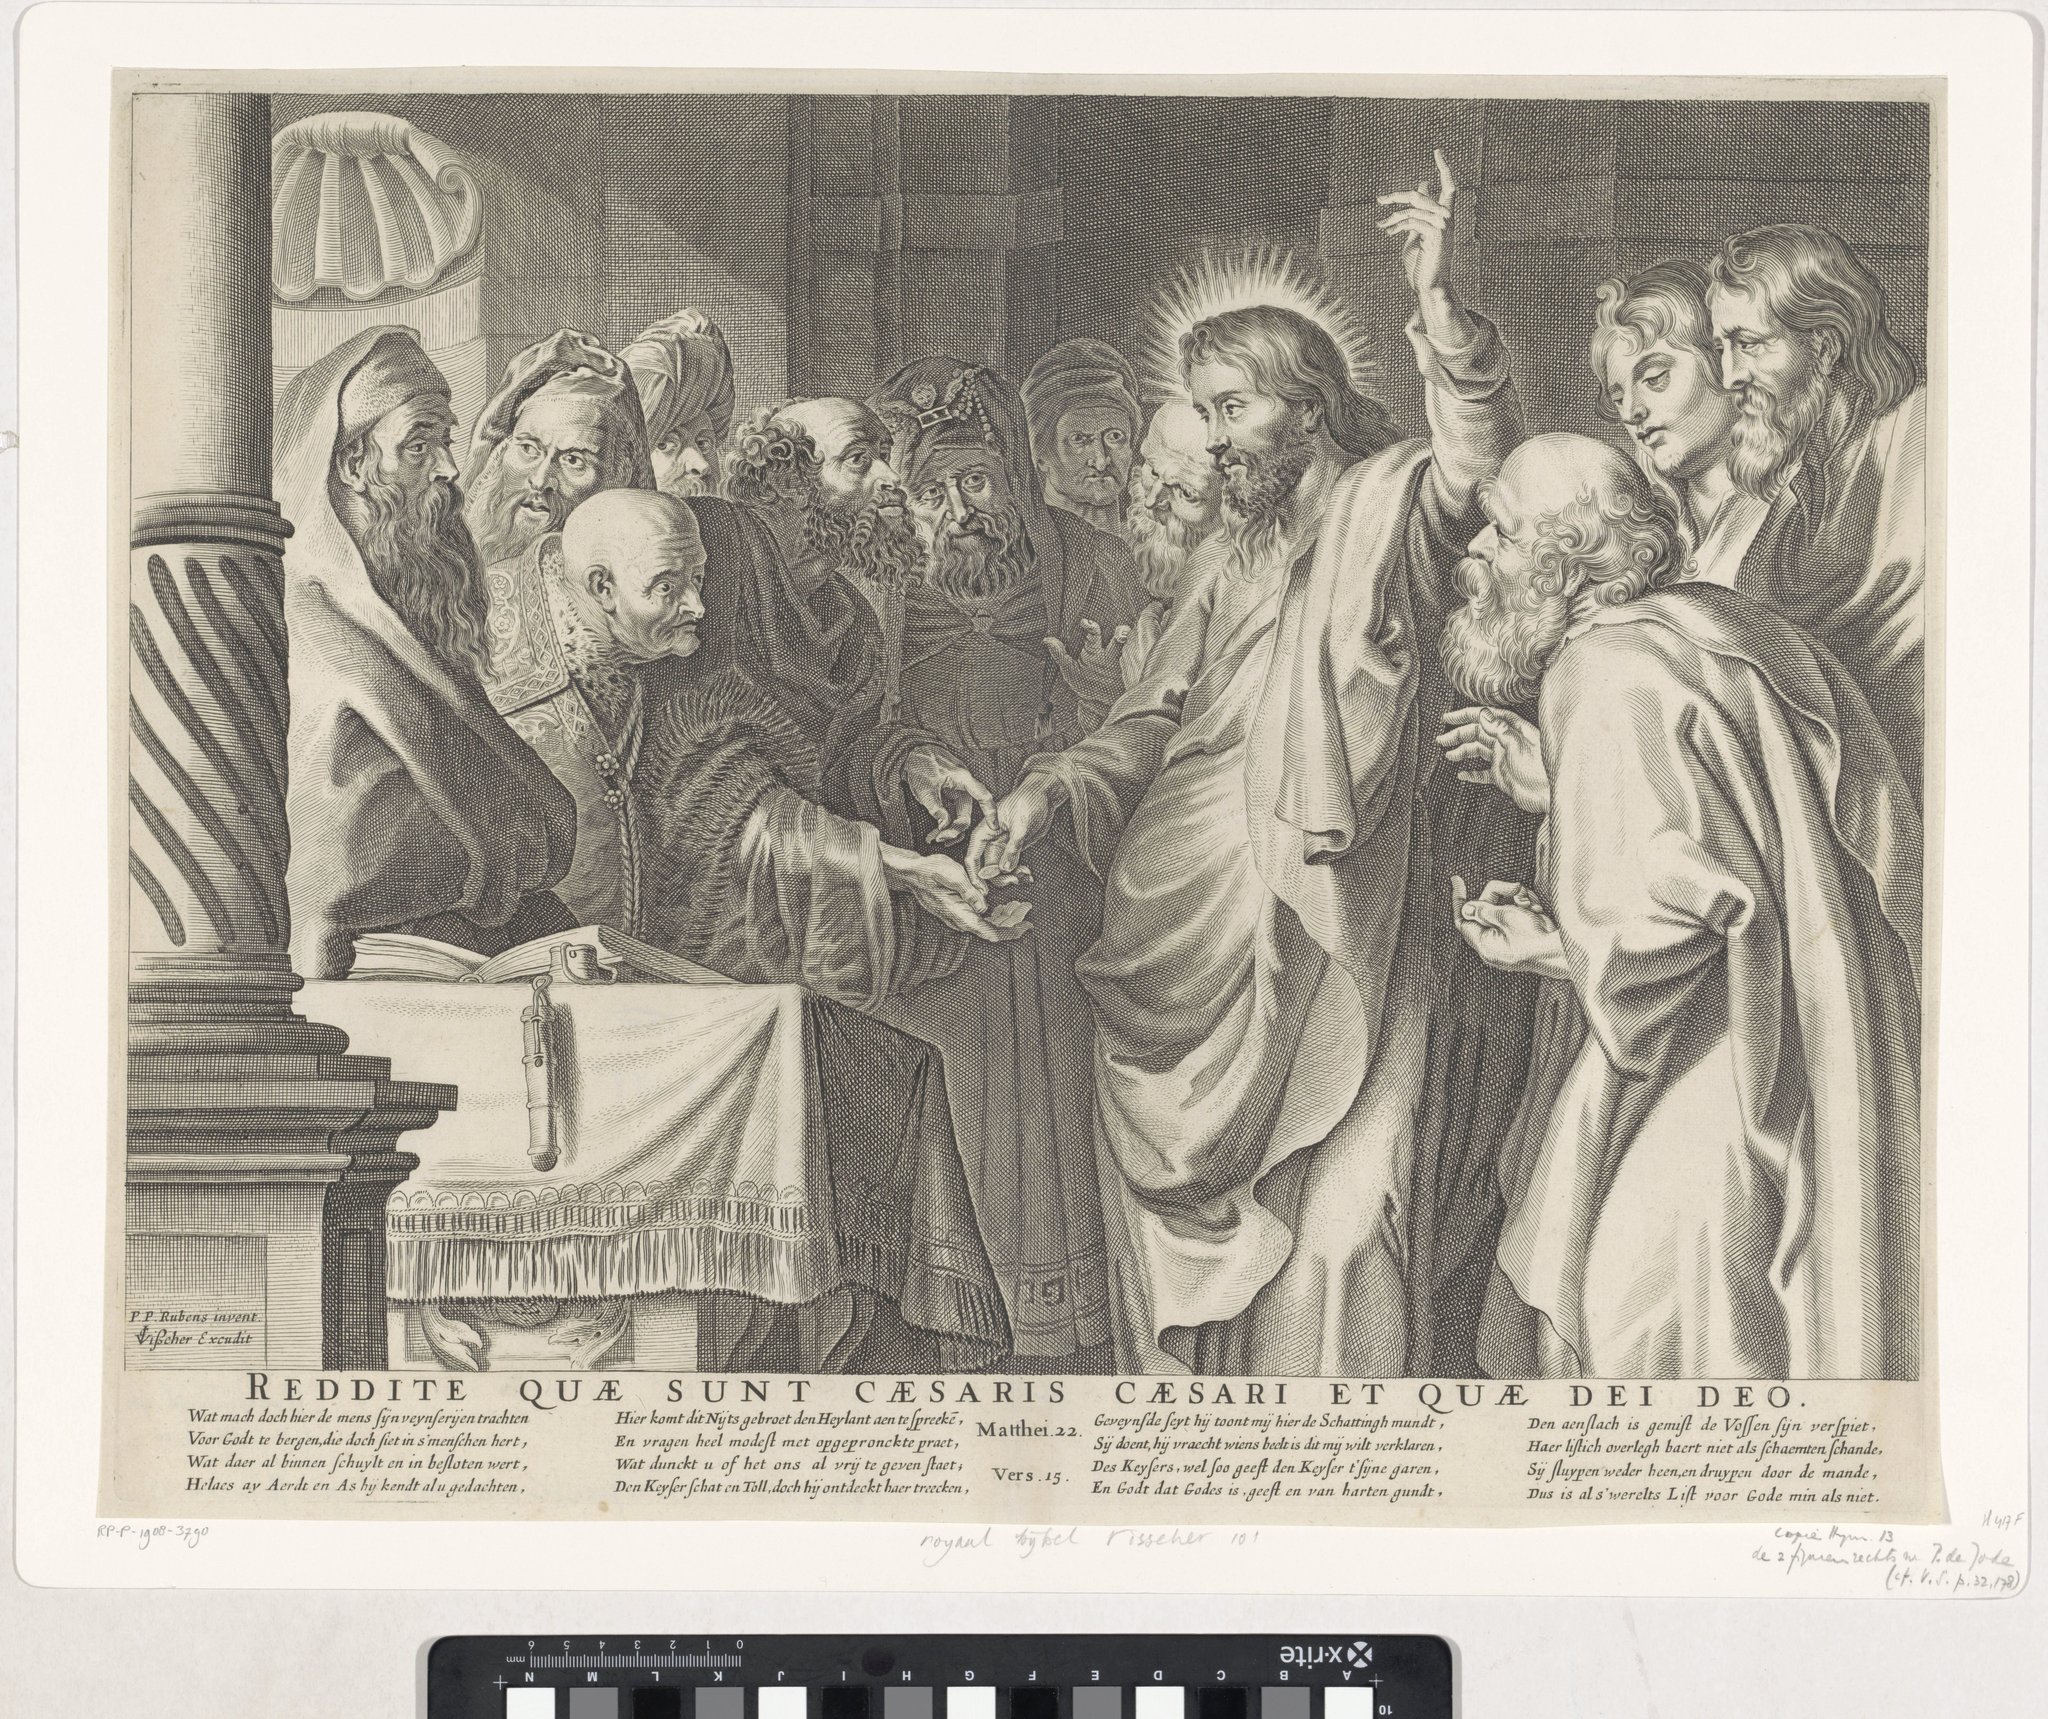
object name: print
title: Royaalbijbel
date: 1630-1652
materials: paper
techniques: engraving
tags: christ (in the temple) in debate with pharisees about the tribute to caesar (matthew 22:15-22; mark 12:13-17; luke 20:20-26)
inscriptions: collector's mark: Lugt 2228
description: De Amsterdamse uitgever Claes Jansz. Visscher (II) produceerde vanaf de jaren ’30 van de zeventiende eeuw grote Bijbelse prenten op zogenaamd royaal-formaat papier (ca. 480 x 580 mm). Na zijn dood in 1652 zette zijn zoon Nicolaes Visscher (I) het bedrijf voort en zo ook de uitgave van Royaalbijbelprenten. Toen Nicolaes in 1679 overleed nam zijn zoon Nicolaes Visscher (II) het bedrijf over en gaf kort hierna, omstreeks 1680, een fondslijst uit. Hierin worden 130 prenten met Bijbelse voorstellingen op royaalpapier beschreven (zie documentatie J. van der Waals). Complete prentbijbels op royaal-formaat werden door vader en zoon Nicolaes Visscher uitgegeven onder de titel Historiae Sacrae Veteris et Novi Testamenti. De bladen werden echter ook los verkocht en konden worden gecombineerd met Royaalbijbel-prenten van andere uitgevers. Verschillende Amsterdamse uitgevers brachten namelijk ook bijbelprenten op royaal-formaat uit, onder wie Clement de Jonghe en Cornelis Danckerts. De door de firma Visscher uitgegeven prenten zijn veelal vervaardigd door anonieme prentmakers naar voorbeeld van verschillende zestiende- en zeventiende-eeuwse Bijbelse prenten en prentreeksen. Veelal moesten de composities worden aangepast aan het grotere en langgerekte royaal-formaat. Daarnaast zijn er ook grote bladen van bekende prentmakers zoals Jan van Londerseel, Pieter Nolpe, Jacques de Gheyn (II) en Jan Harmensz. Muller opgenomen in de categorie ‘Bybelsche Figuren, op Royaal-bladen’ in de fondslijst van Visscher. Prent mogelijk gebruikt in: Historiae Sacrae Veteris et Novi Testamenti (Royaalbijbel). Amsterdam: Nicolaes Visscher (I) en (II), [1652-1702]. In de fondslijst van Nicolaes Visscher II (ca. 1680) is het onderwerp van deze prent onder de titel 'Bybelsche Figuren, op Royaal-bladen. bestaande uyt de volgende historien.' als volgt genummerd: 101. Het centrale voorstelling naar een prent van Vorsterman naar een schilderij van Rubens. De drie figuren uiterst rechts naar een prent van de Jode.